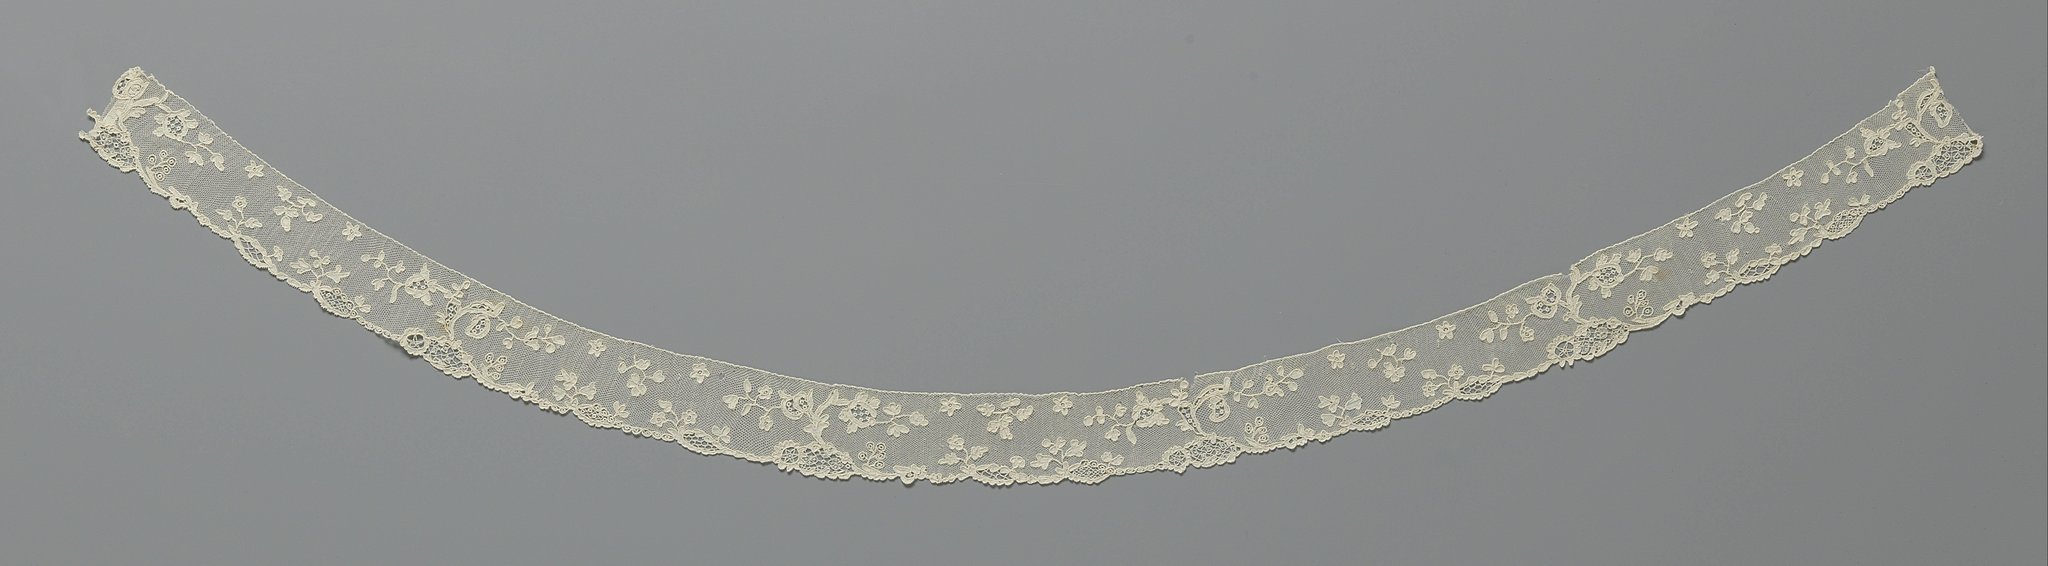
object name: womenswear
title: Berthe van naaldkant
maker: Anonymous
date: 1770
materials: lace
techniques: lace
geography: france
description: Berthe van naaldkant met een geschulpte rand die bestaat uit ovale medaillons die met elkaar worden verbonden door slingers. Uit de medaillons groeien verschillende bloemen. Strooibloemen sieren de grond.